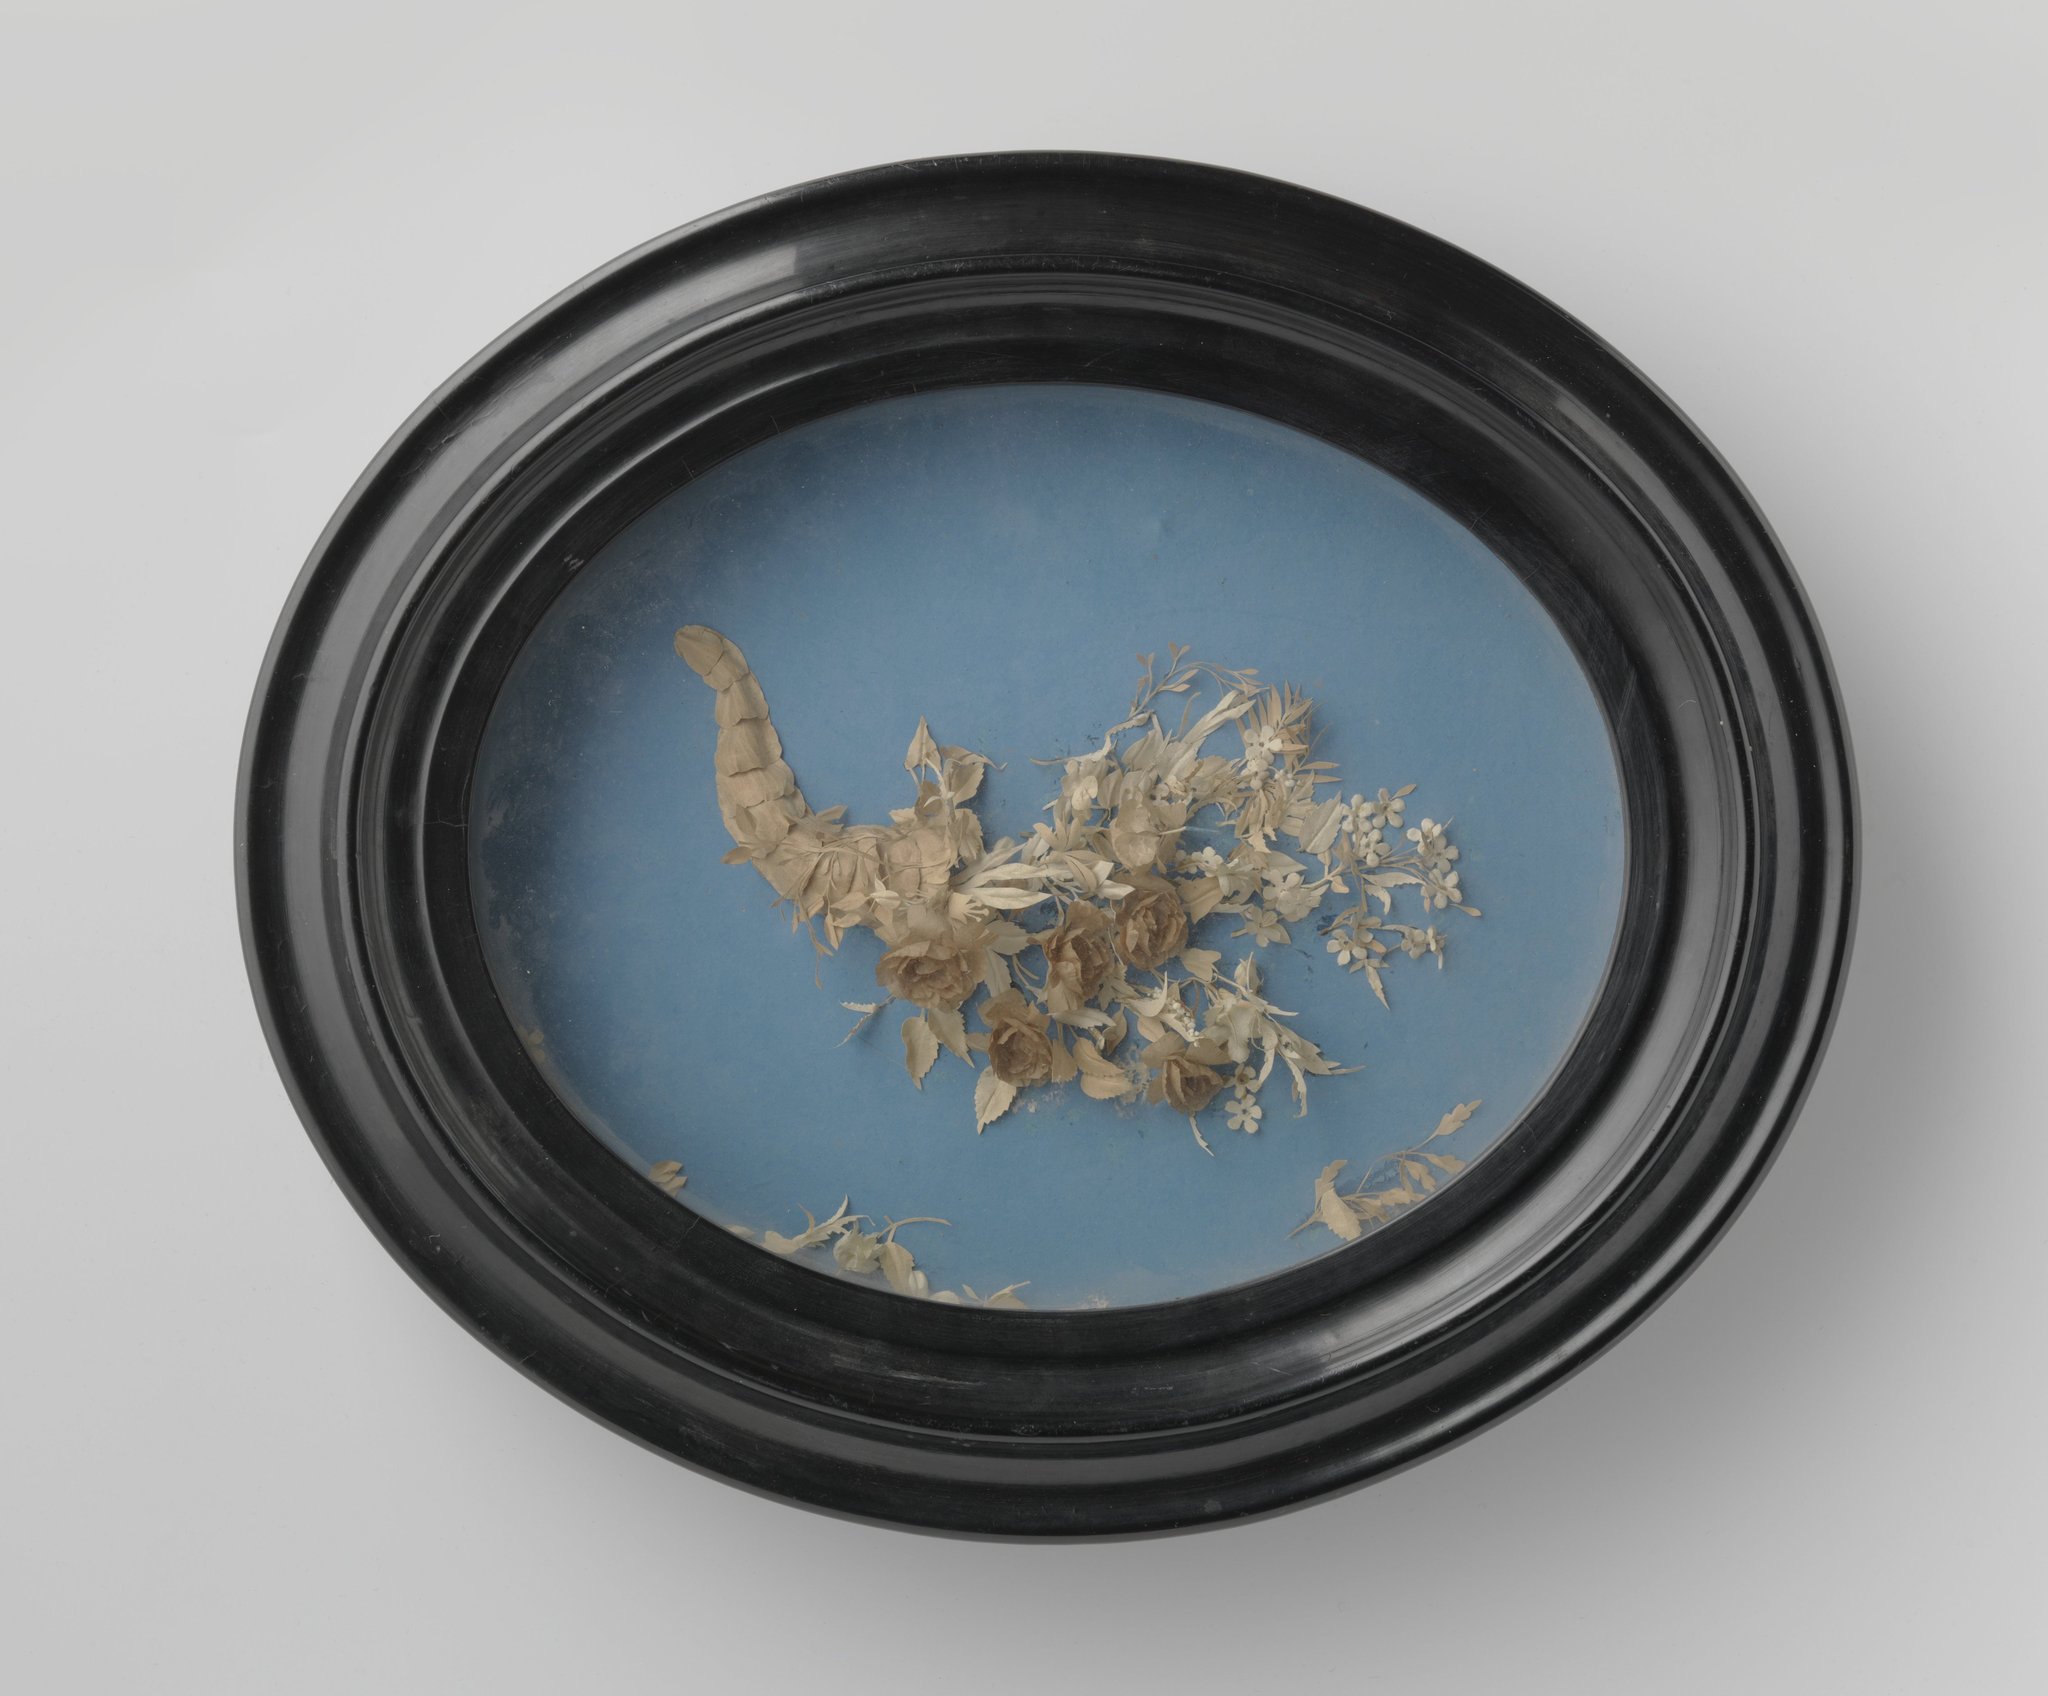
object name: cut paper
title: Bloemenboeket in een hoorn des overvloeds.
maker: Anonymous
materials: glass, paper, wood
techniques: cutting, snipping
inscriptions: inscription and date: ‘Geknipt voor mijn lief peetekindje Alida, door hare Grootmoeder. Leeuwarden Juli 1865.’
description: Bloemenboeket en hoorn des overvloeds van geknipt papier, gemonteerd op een blauwe papieren achtergrond.